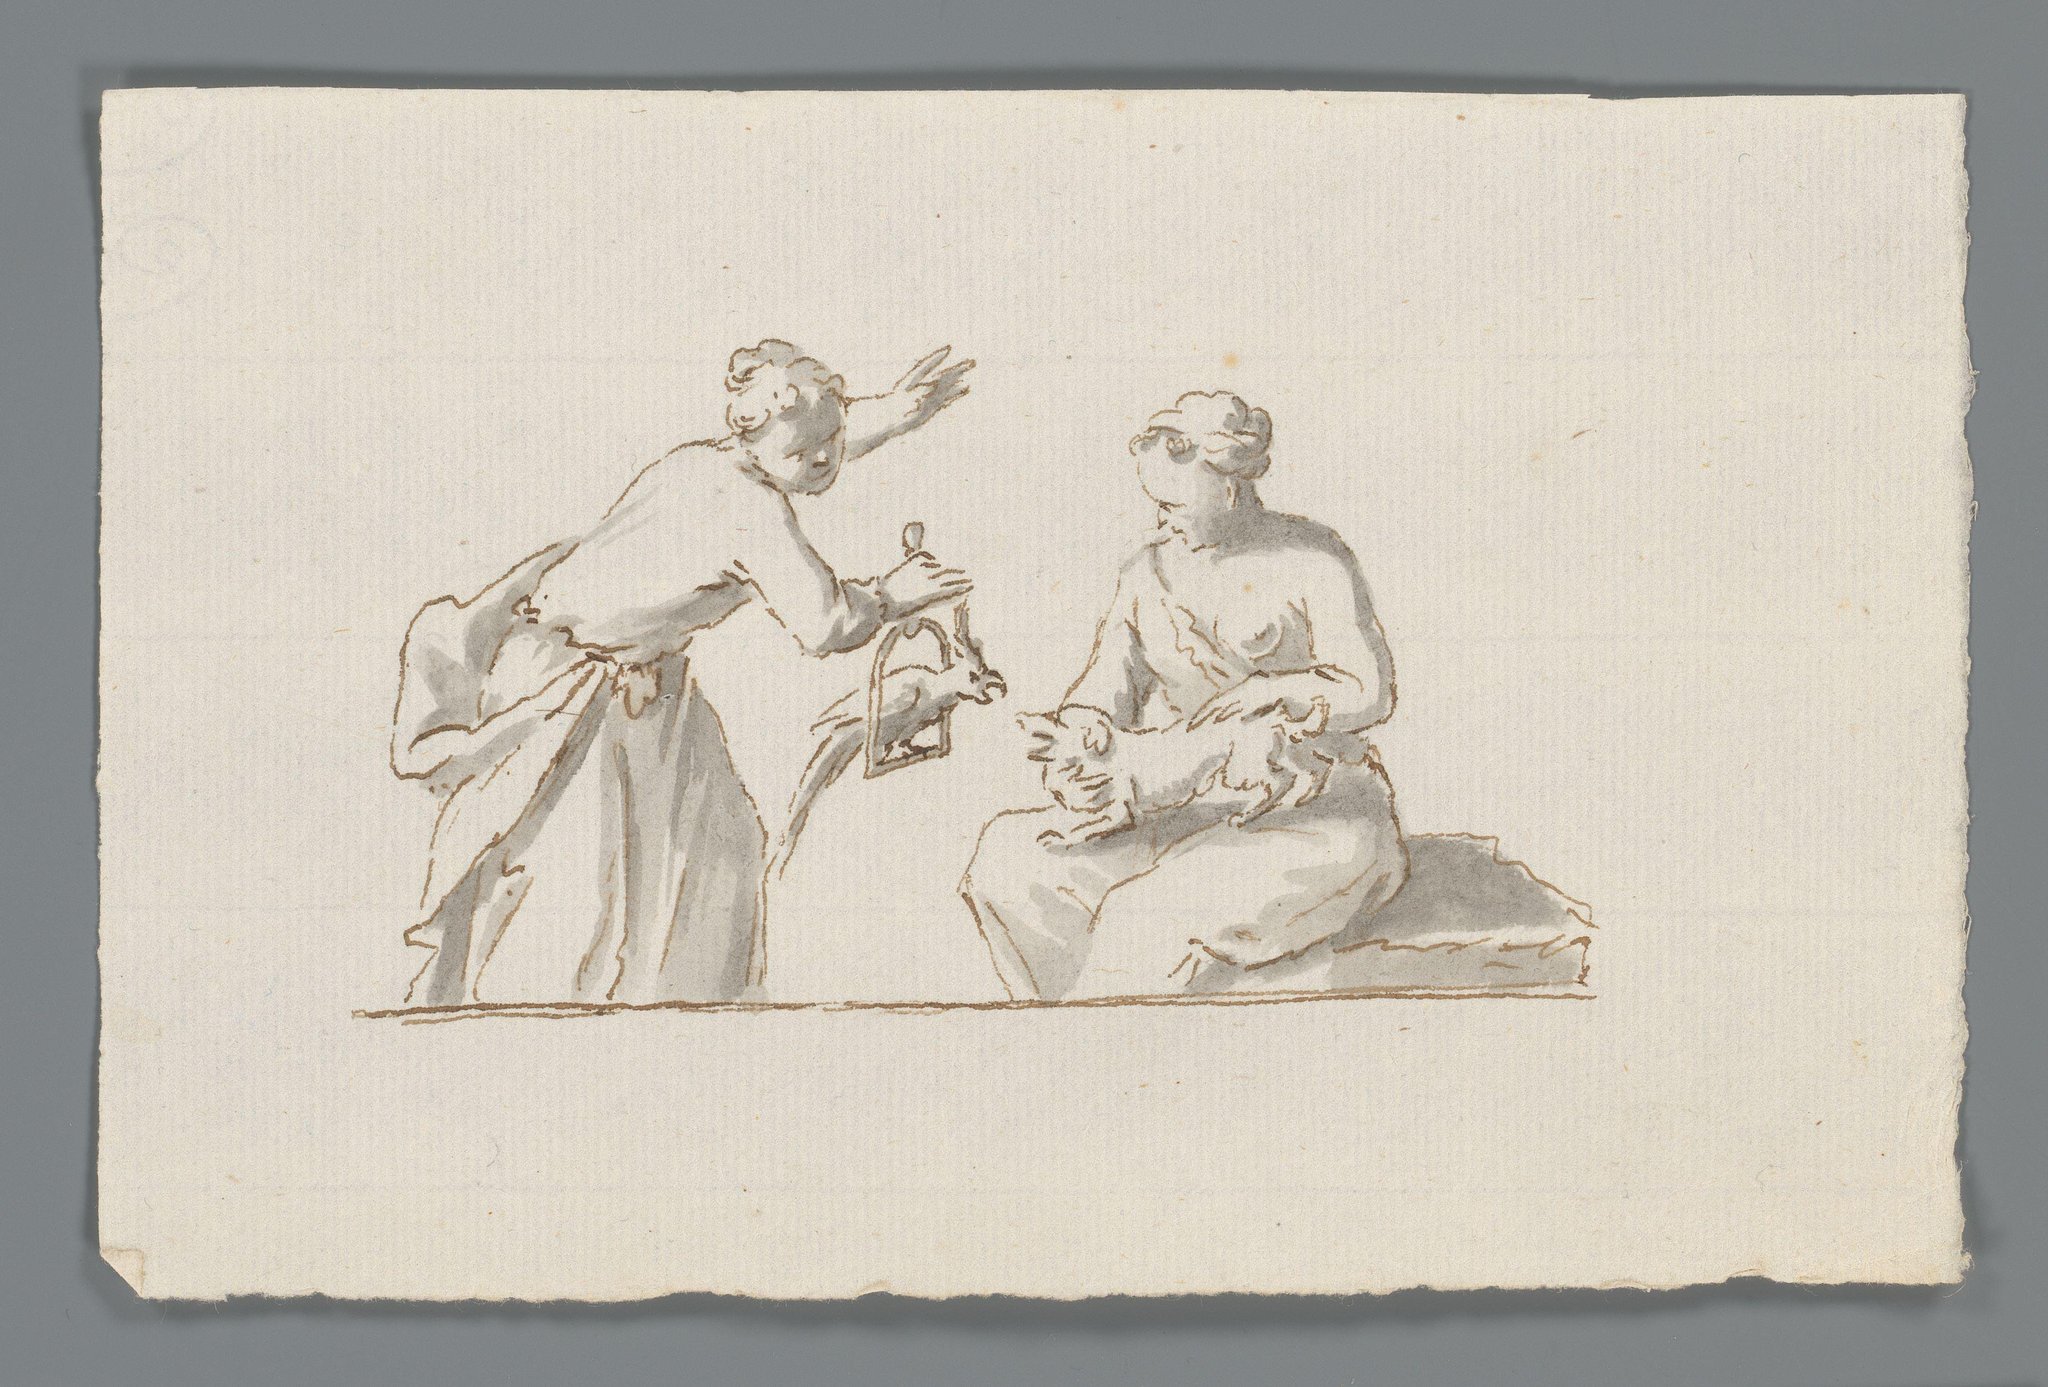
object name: drawing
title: Twee vrouwen met een kaketoe en een hondje die ruziën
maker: matthijs balen (1684-1766)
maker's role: draughtsman, painter, print maker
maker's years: 1684-1766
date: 1694-1766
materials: paper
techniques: brush, pen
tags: female sex; woman, ornamental birds: cockatoo, dog